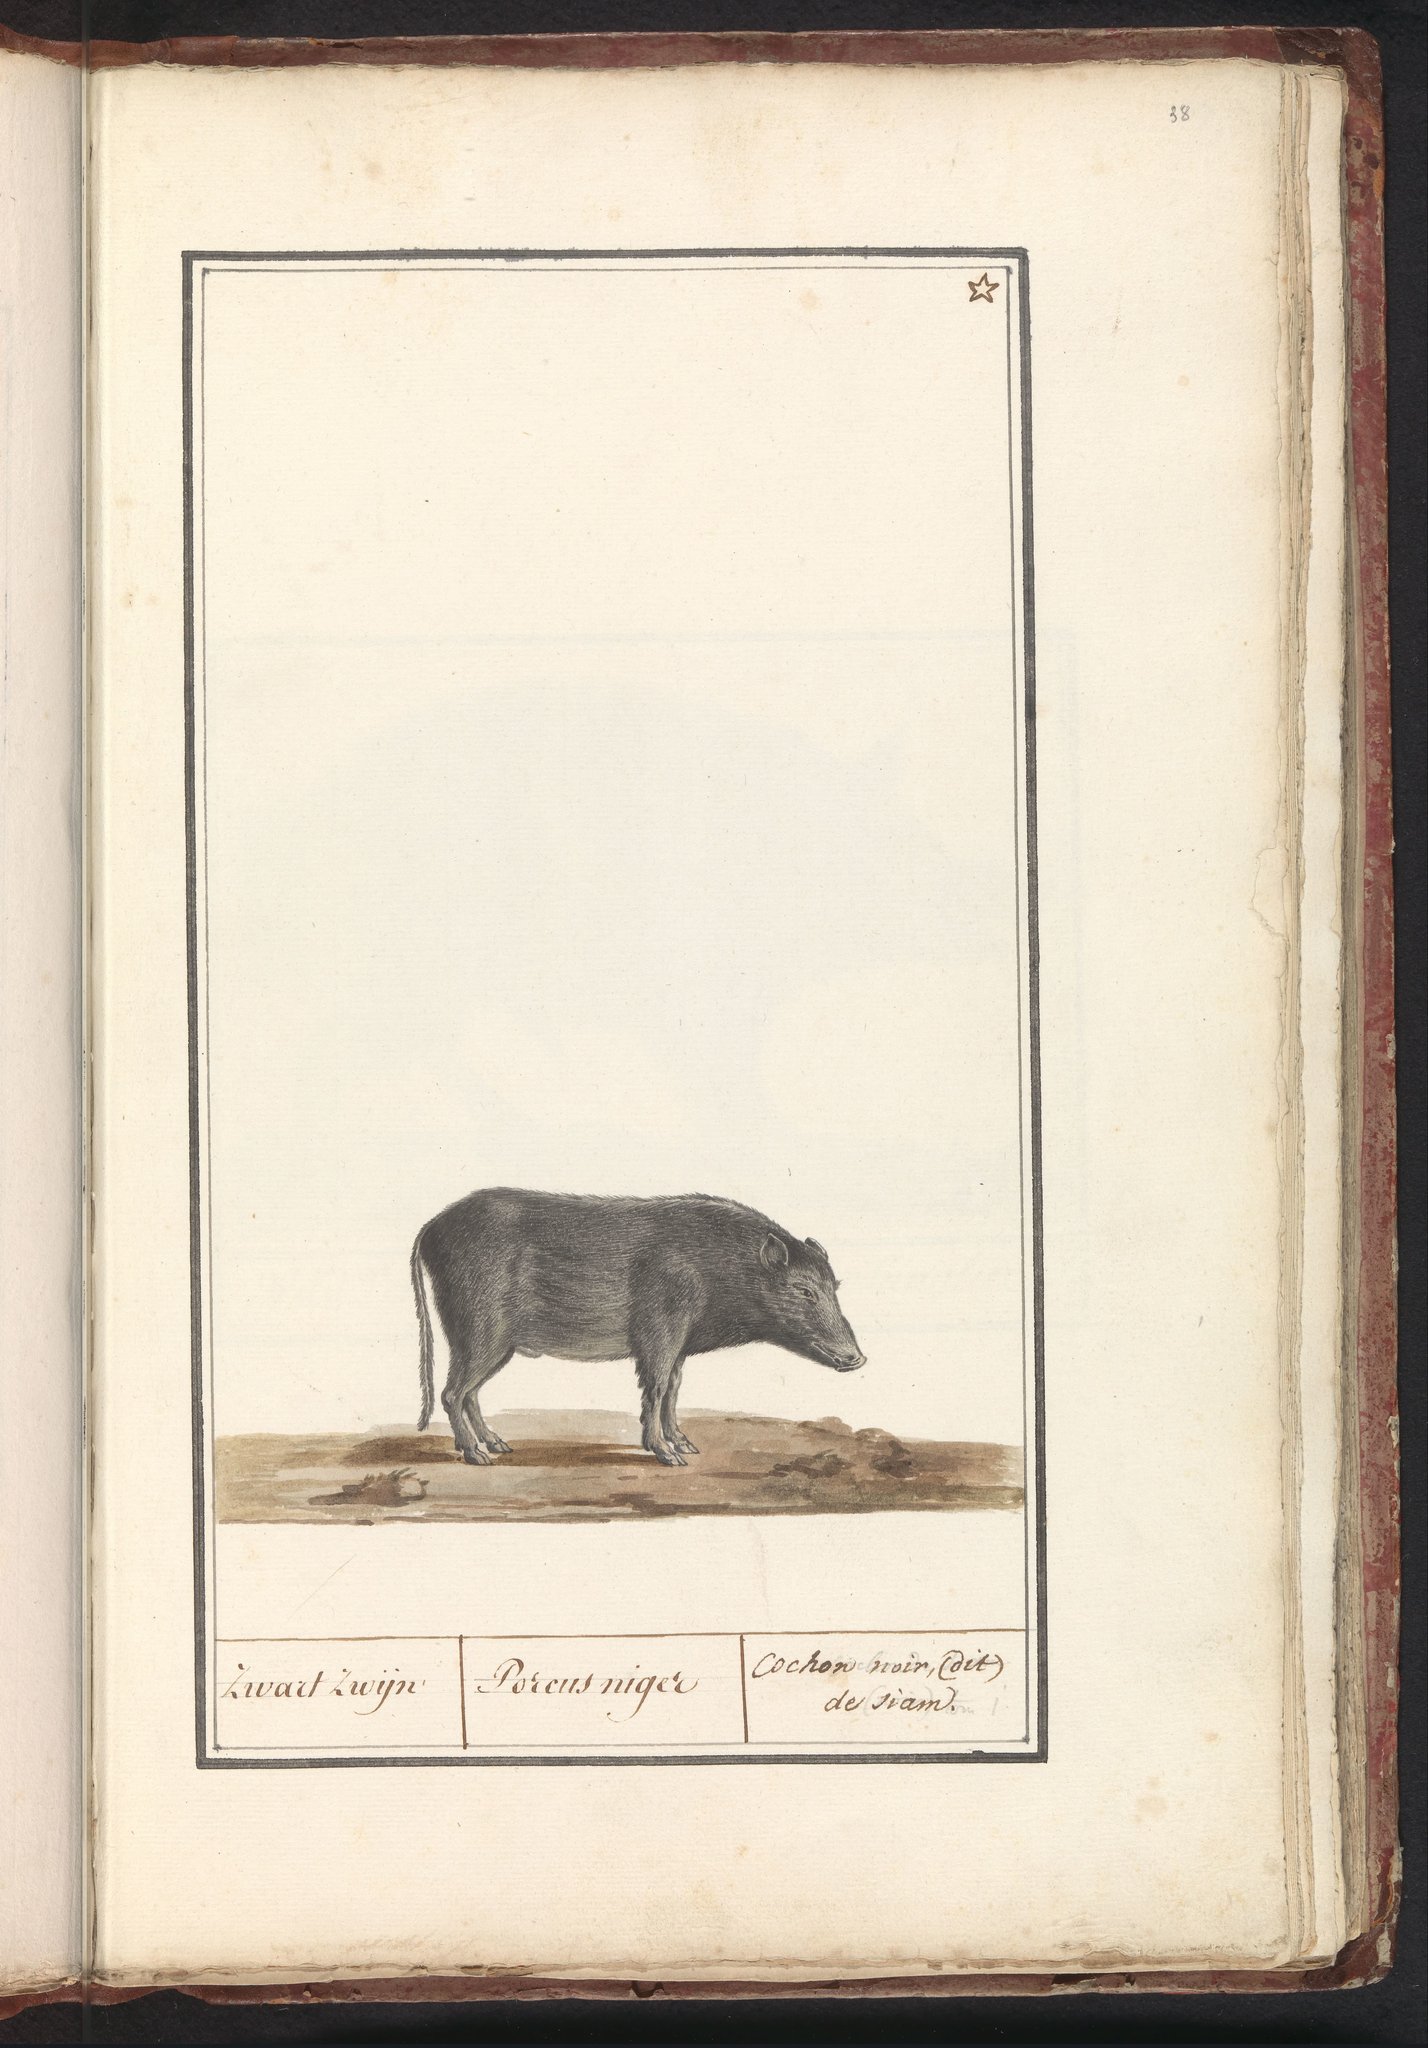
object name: drawing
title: Zwart zwijn / Porcus niger / Cochon noir, (dit) de siam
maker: Anonymous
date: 1790-1814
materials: paint, paper, watercolor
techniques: brush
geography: southern netherlands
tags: pig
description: Een zwart tam varken. Ongenummerd. Rechtsboven gemerkt met een sterretje. Onderdeel van het eerste album met tekeningen van viervoeters. Eerste van twaalf albums met tekeningen van dieren, vogels en planten bekend rond 1600, gemaakt in opdracht van keizer Rudolf II. Met toelichting in Nederlands, Latijn en Frans.